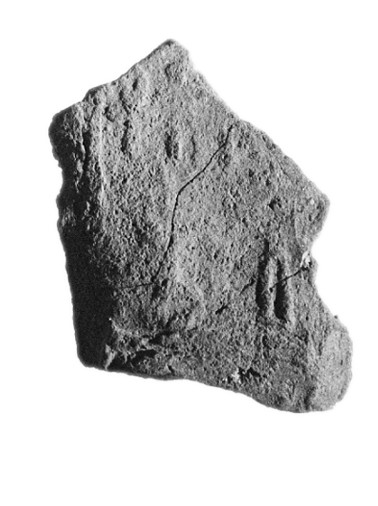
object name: sealing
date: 2030-1640 BCE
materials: clay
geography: egypt